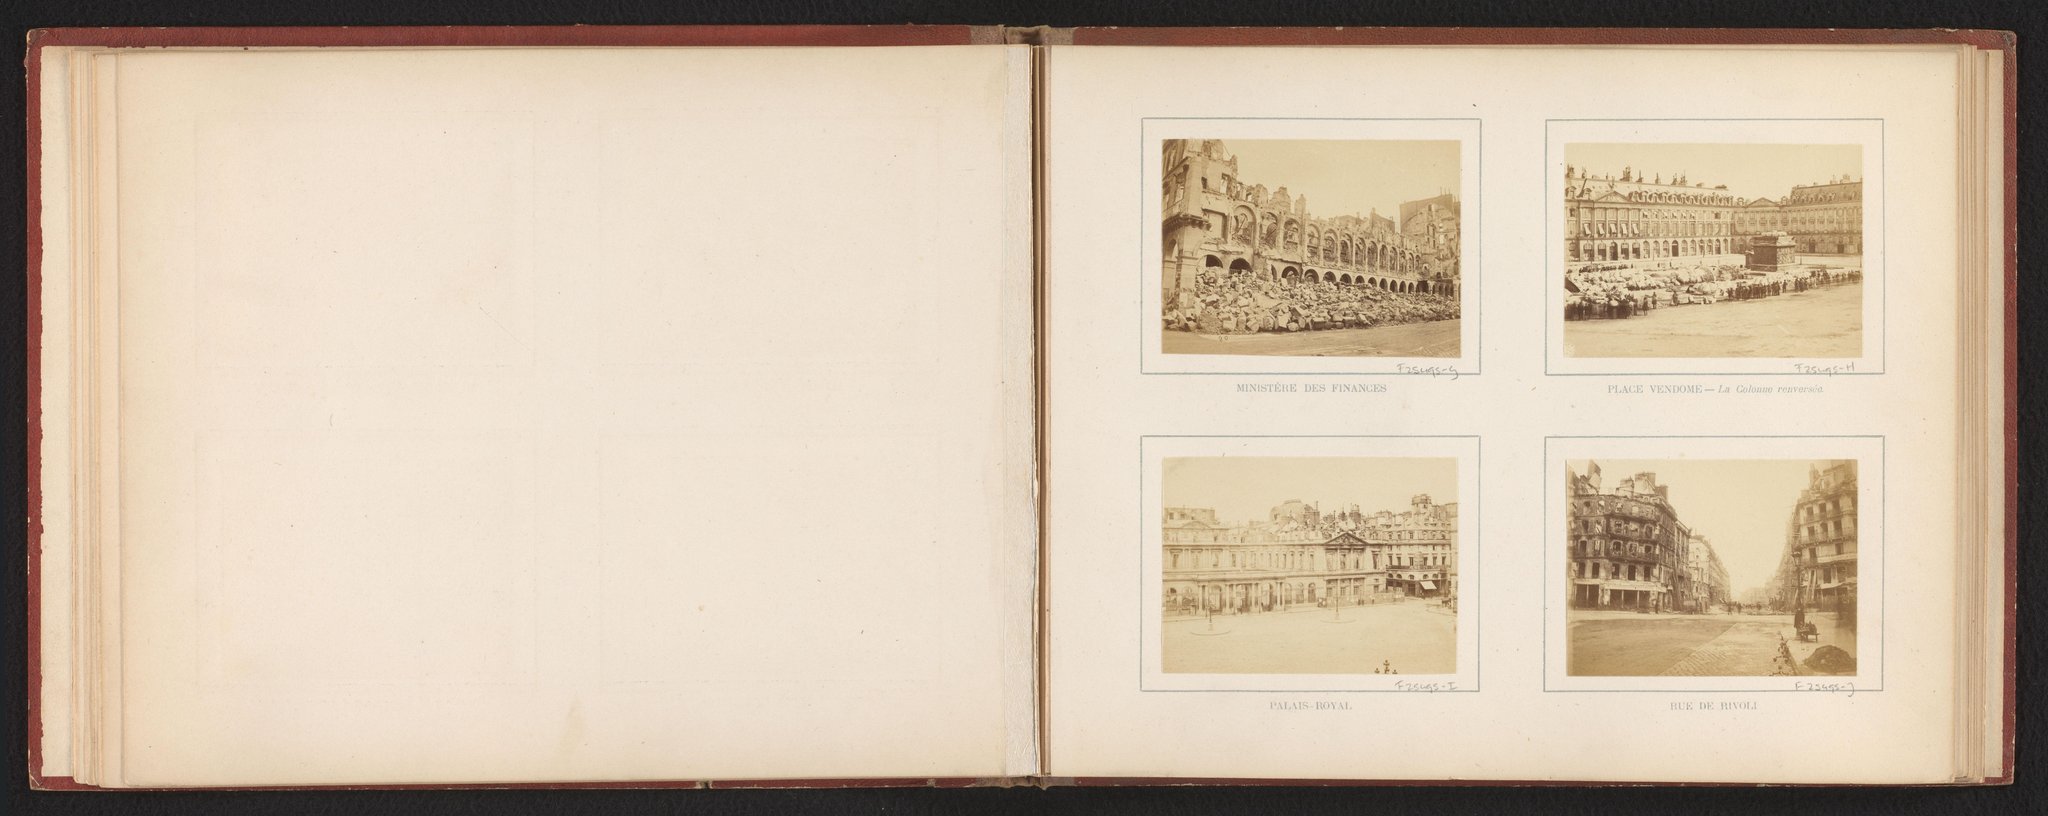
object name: photograph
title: Place Vendome - La Colonne renversée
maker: Anonymous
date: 1871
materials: paper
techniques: albumen print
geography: place vendôme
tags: ruin of a building ~ architecture